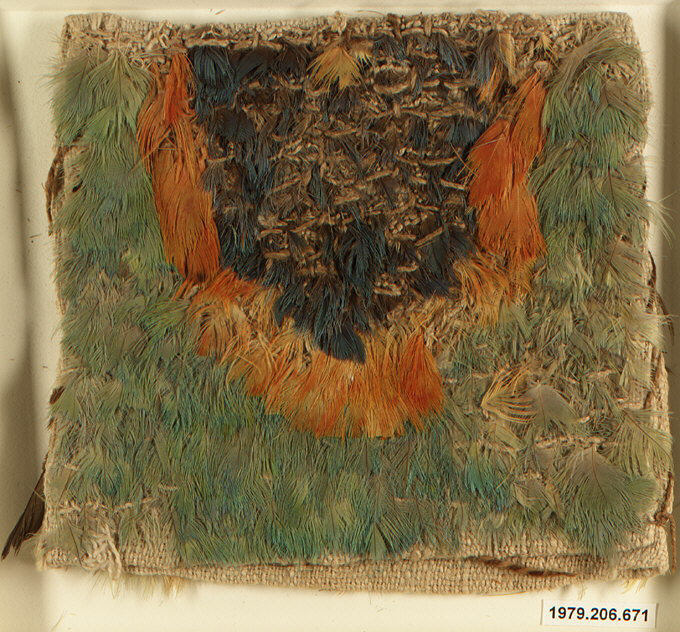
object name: miniature tunic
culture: ica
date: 1101-1300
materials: cotton, feather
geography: peru